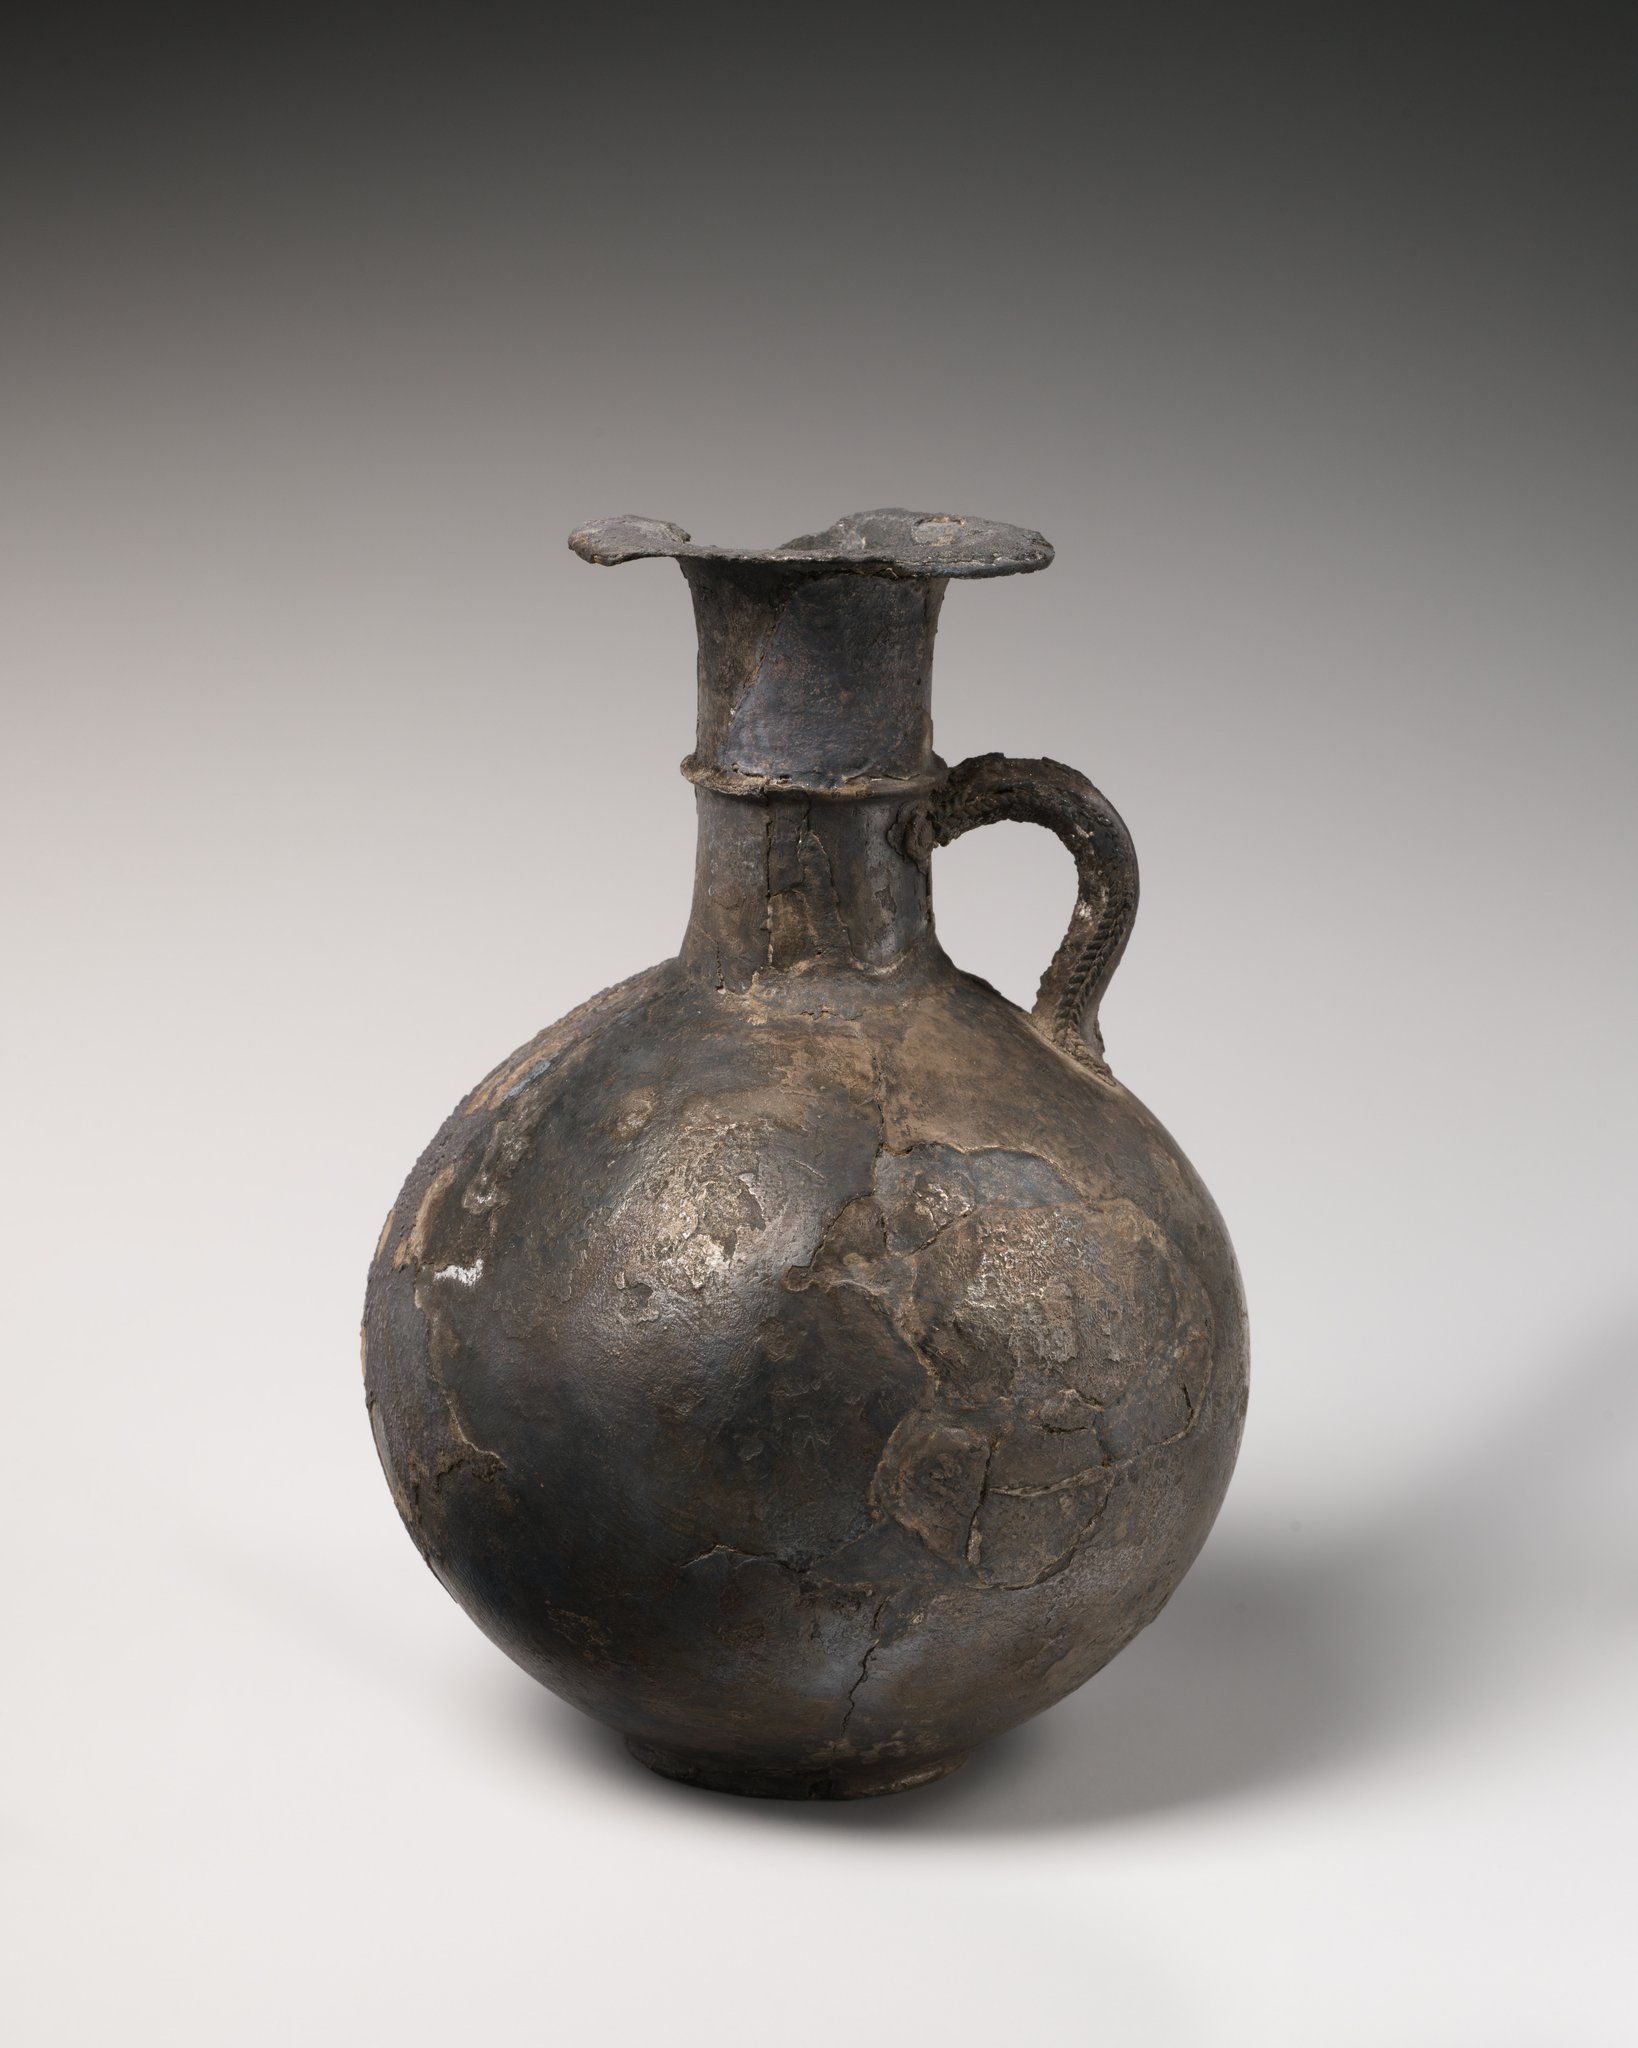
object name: jug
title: Silver jug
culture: cypriot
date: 600 BCE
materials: silver